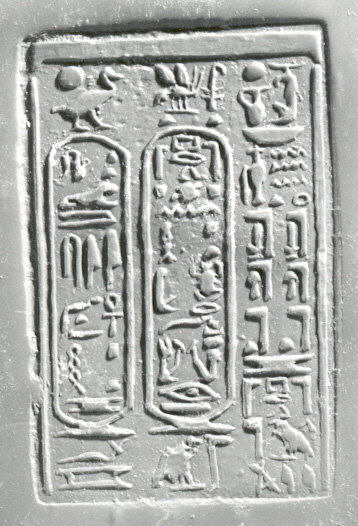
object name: stamp seal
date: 180-145 BCE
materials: bronze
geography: egypt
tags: hieroglyphs